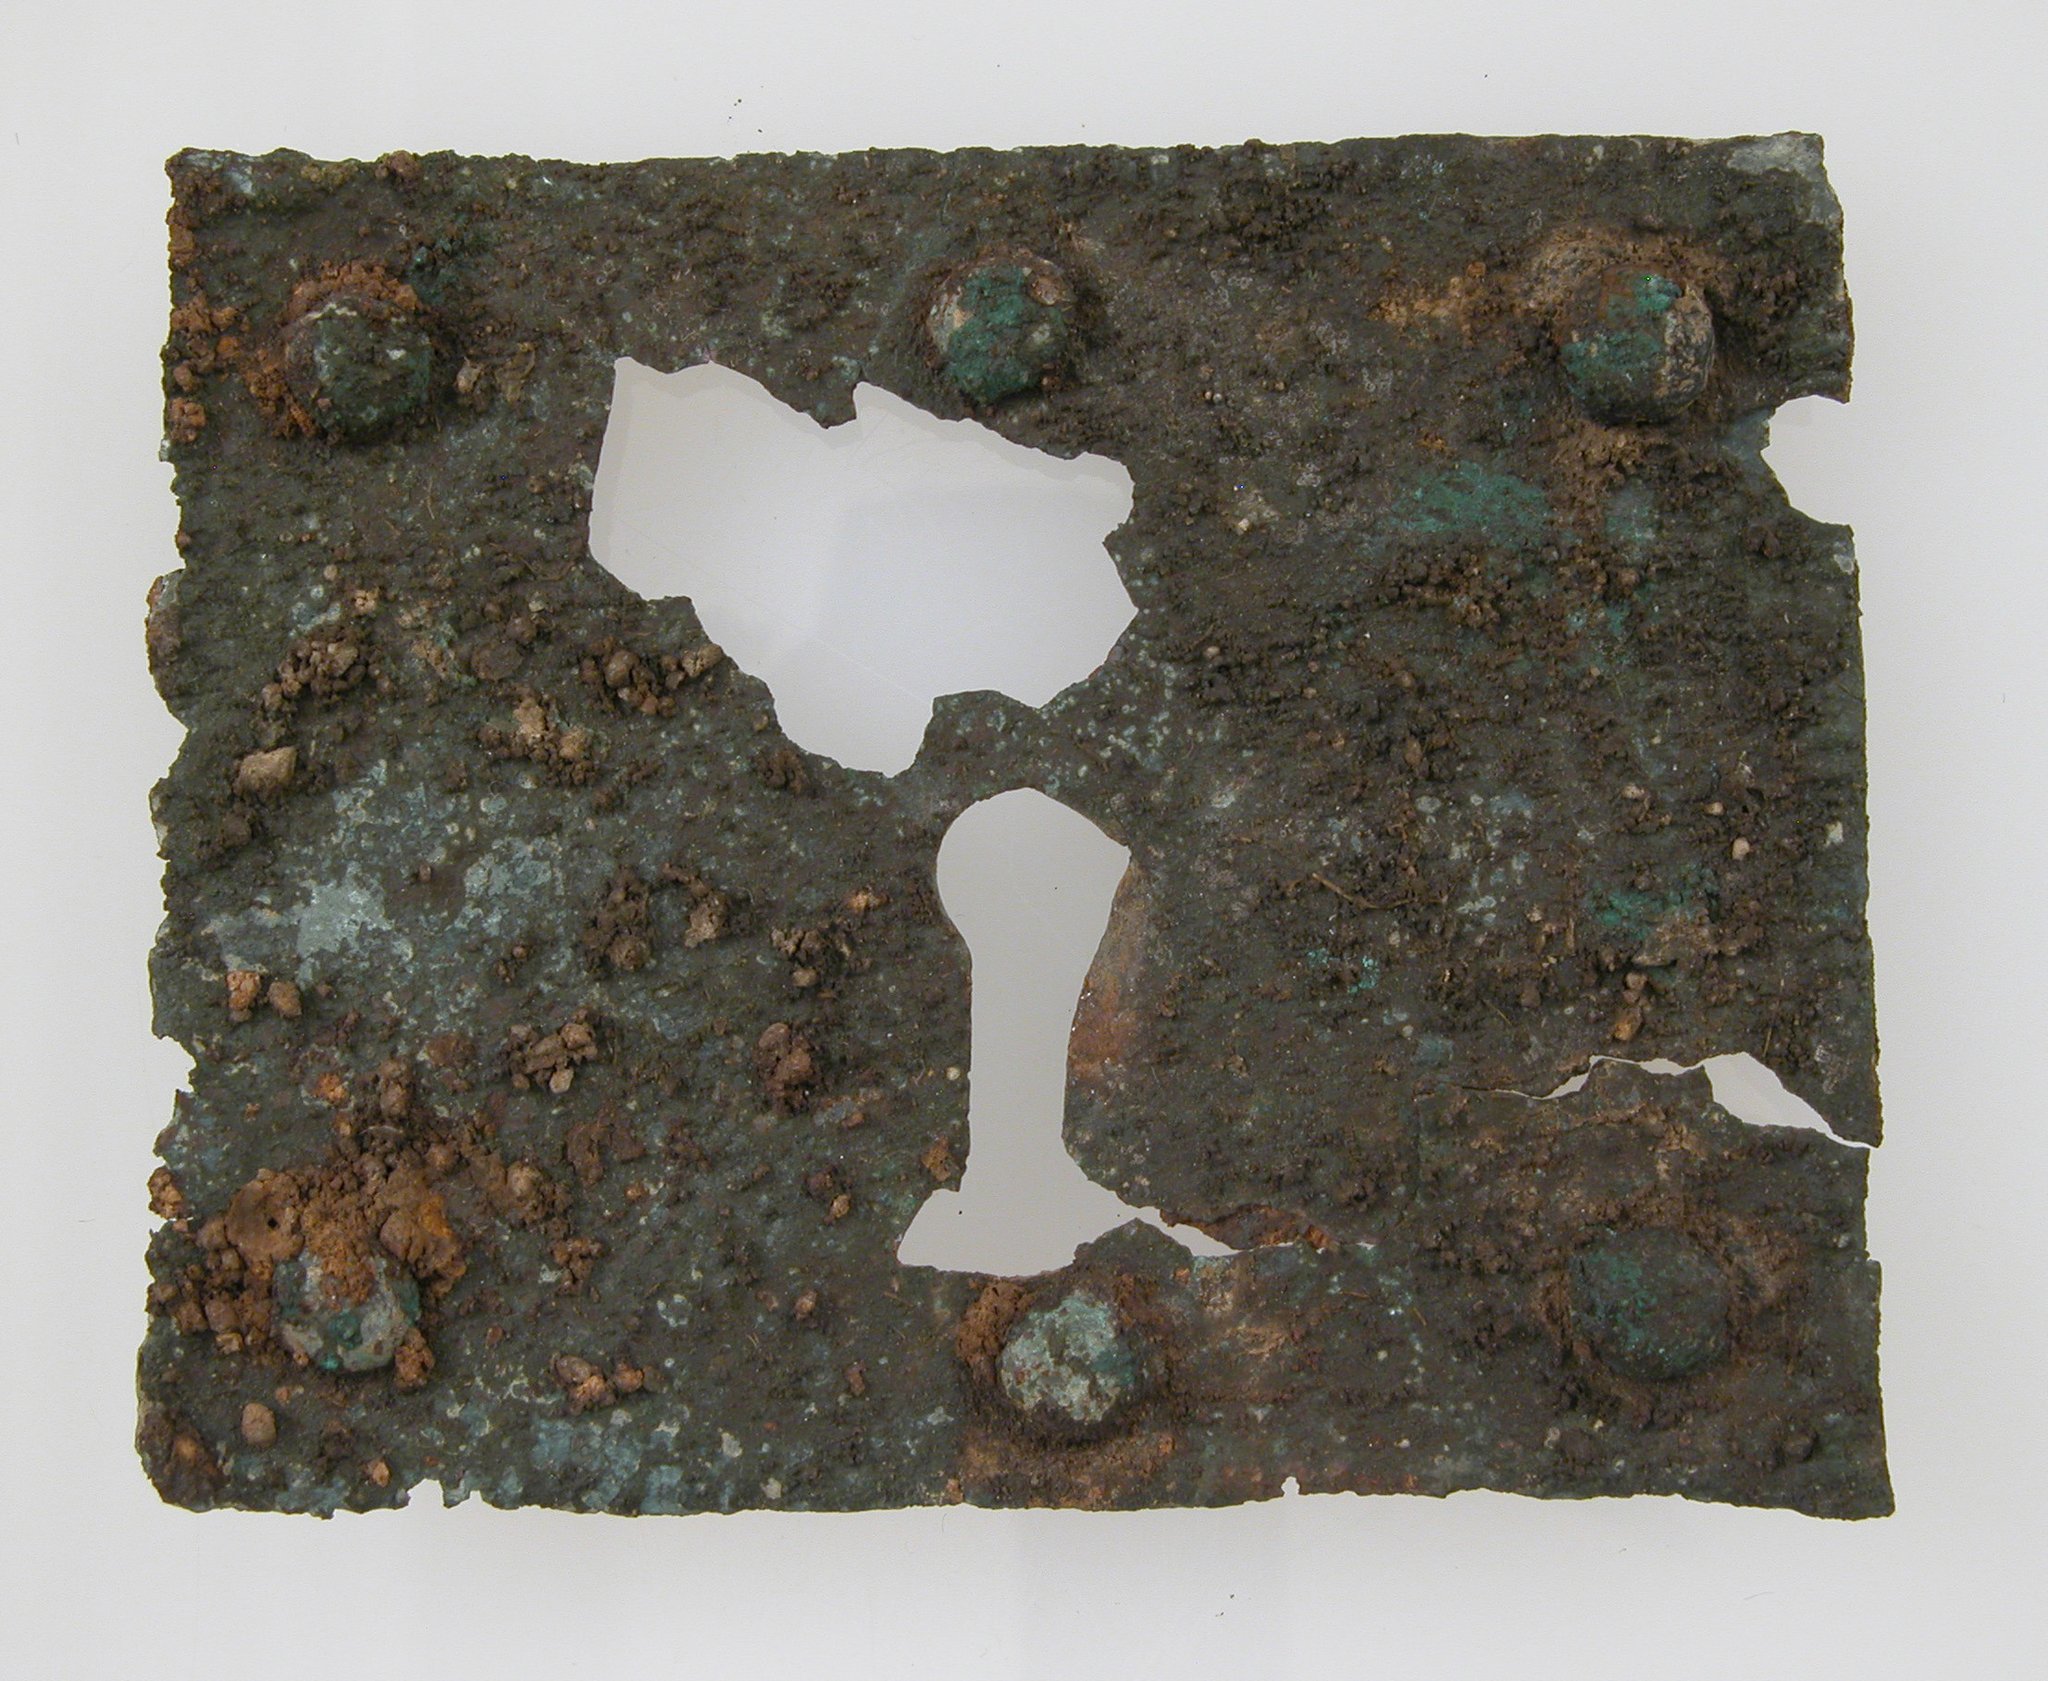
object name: plaque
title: Rectangular Plaque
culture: frankish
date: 501-700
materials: copper alloy, wood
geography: germany